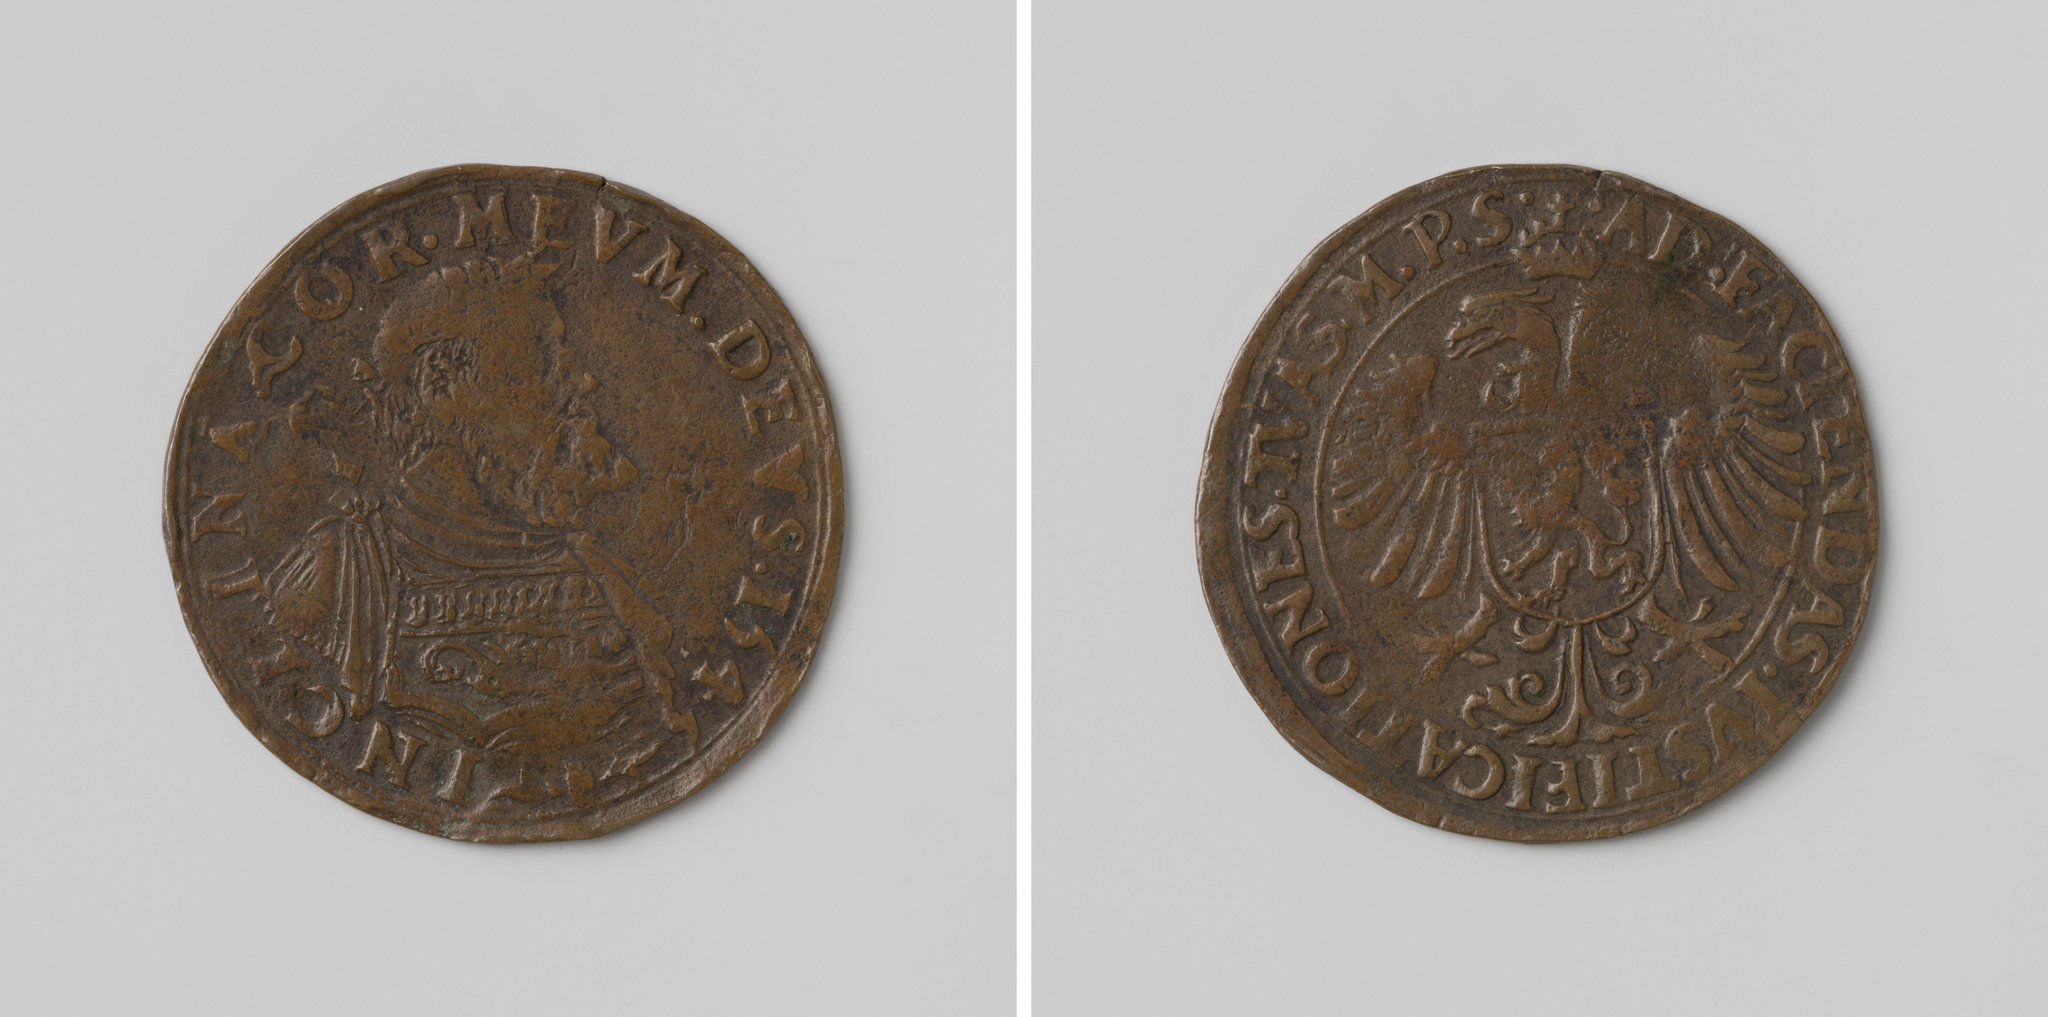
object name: jeton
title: Karel V, Duits keizer, wenst vrede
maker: Anonymous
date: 1545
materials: copper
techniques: striking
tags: ghent, charles v (holy roman emperor and king of spain)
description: Koperen penning. Voorzijde: borststuk man met lauwerkrans binnen omschrift. Keerzijde: tweekoppige adelaar onder kroon met wapenschild binnen omschrift